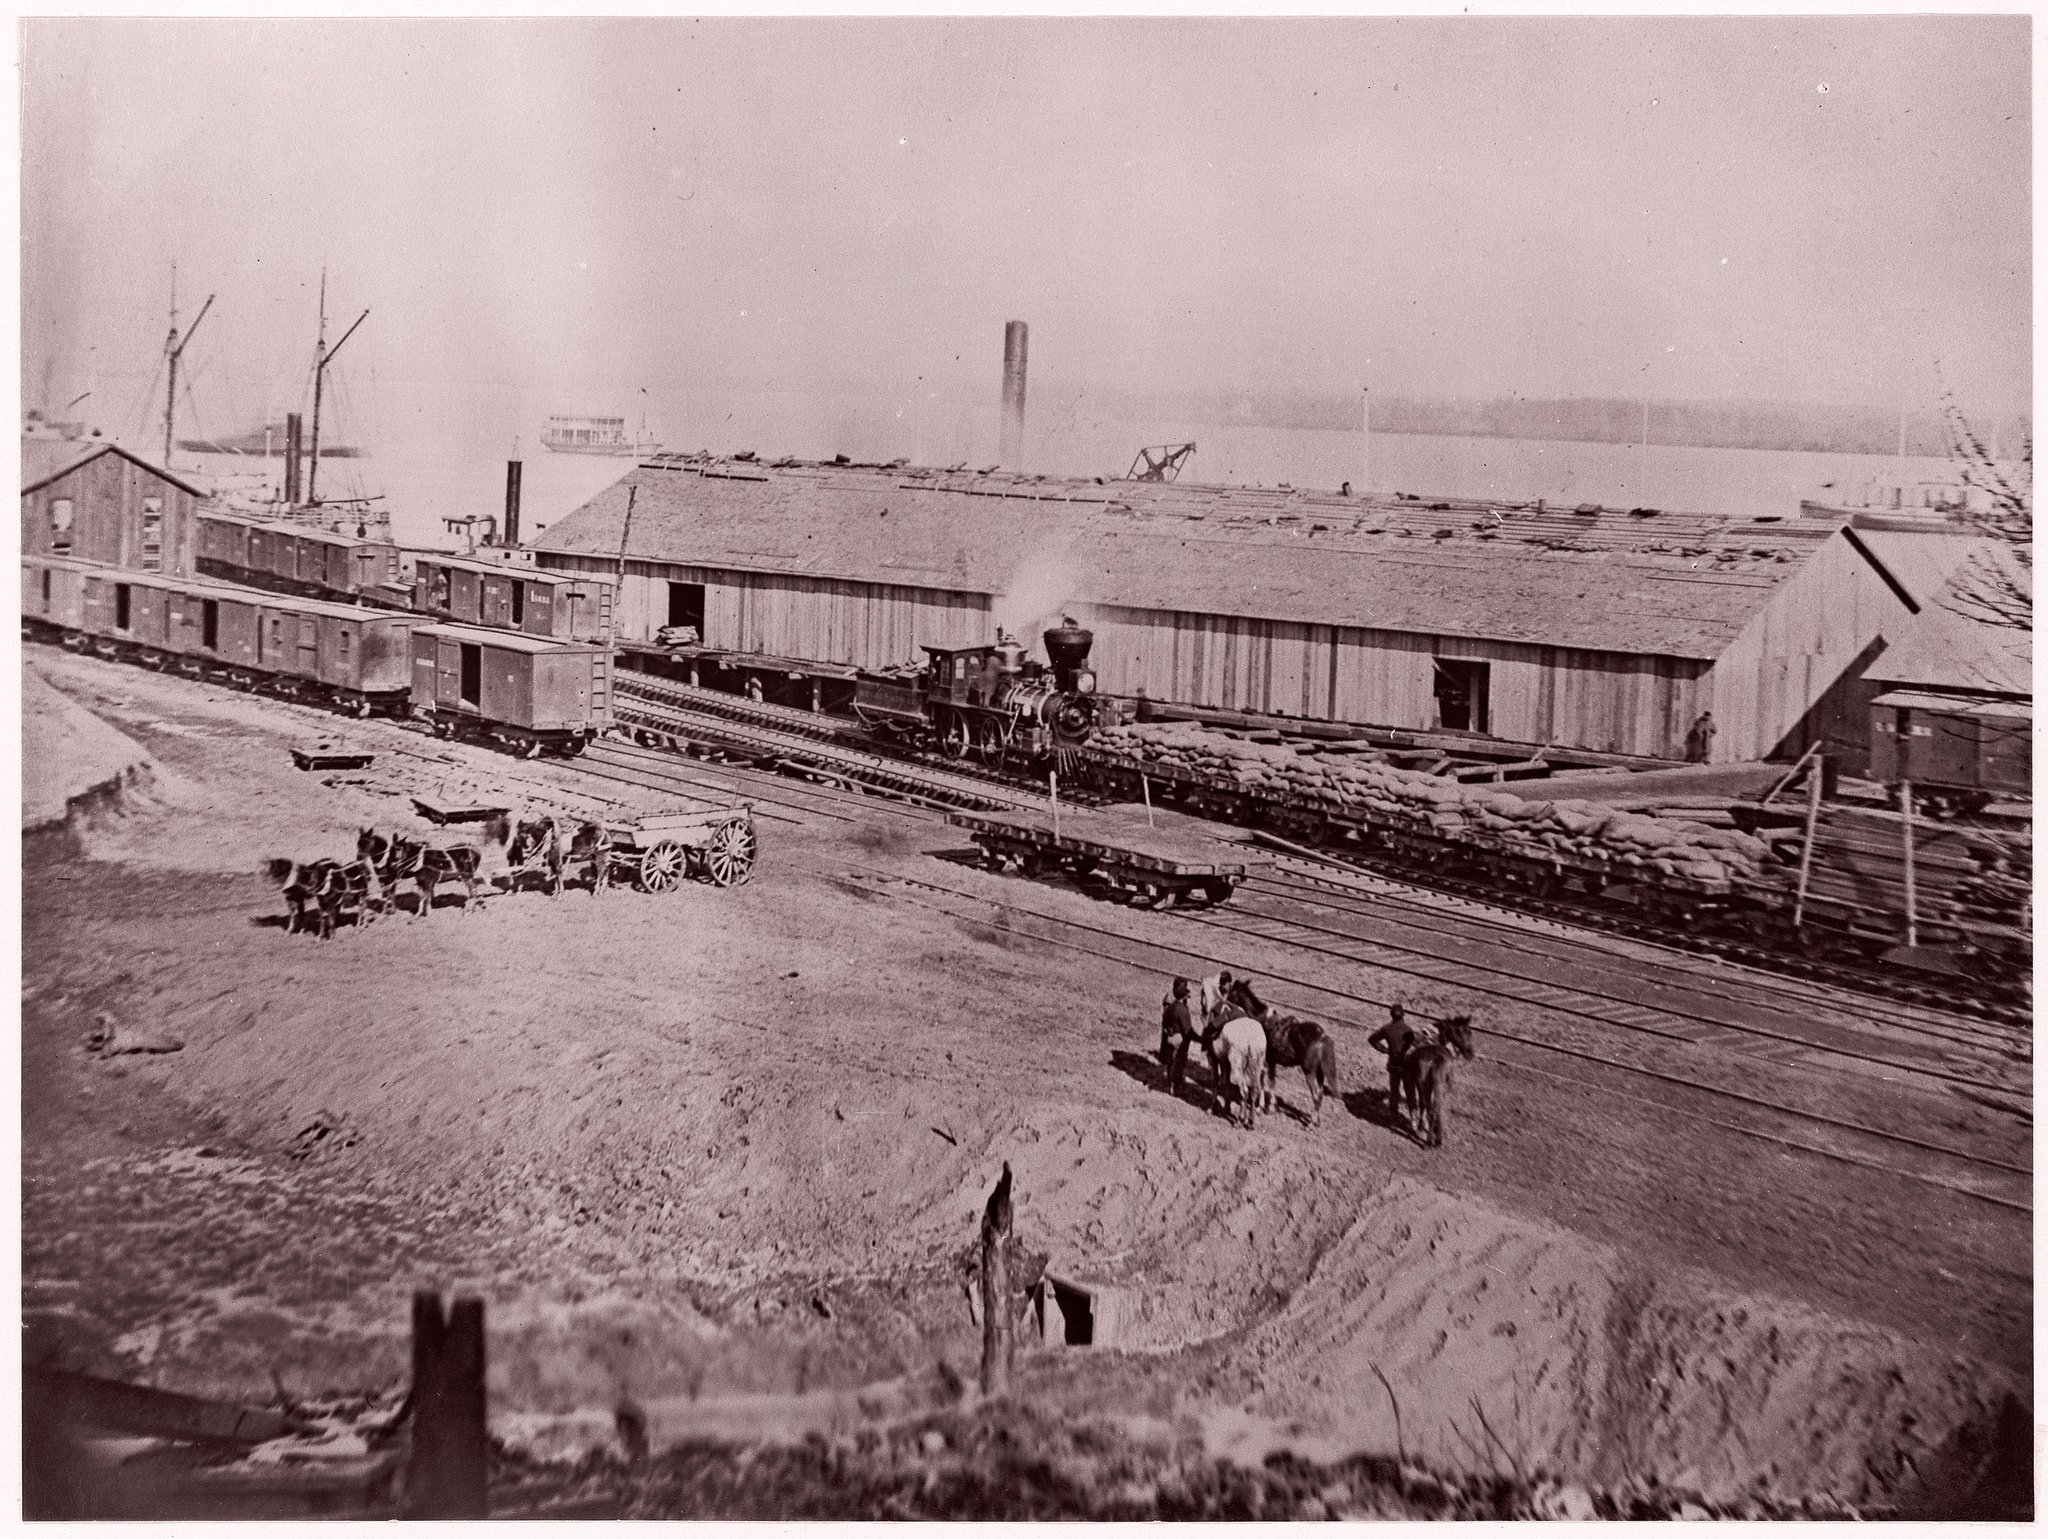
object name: photograph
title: Terminus of U.S. Military Railroad, City Point, Virginia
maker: andrew joseph russell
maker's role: artist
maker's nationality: american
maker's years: 1830-1902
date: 1861-1865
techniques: albumen silver print, glass negative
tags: railways,american civil war,horses,trains